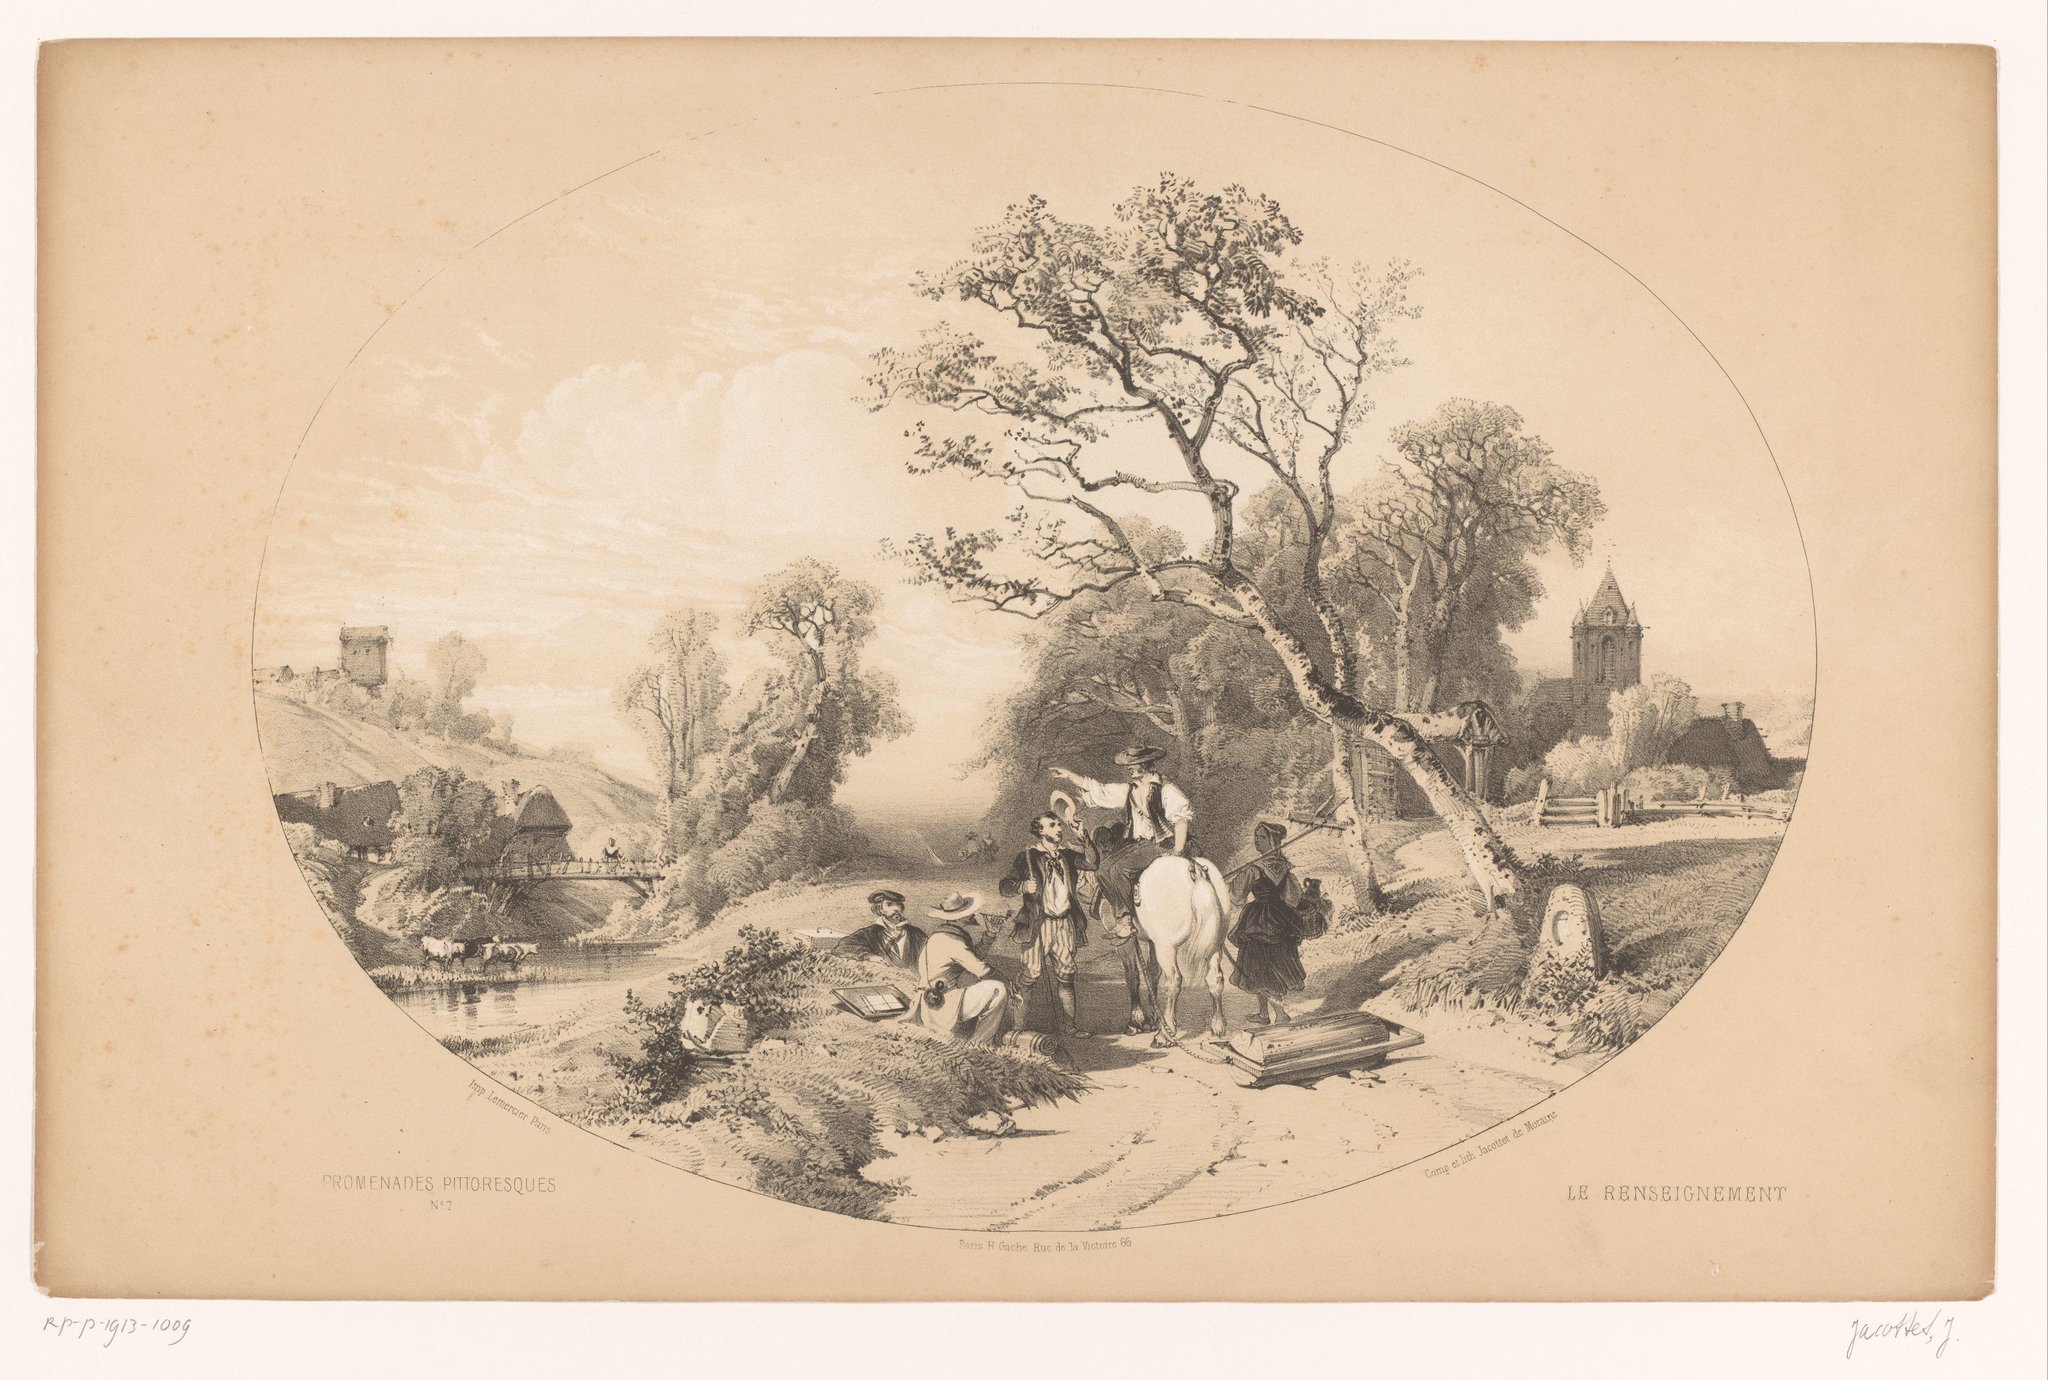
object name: print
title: Pittoreske wandelingen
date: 1850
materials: paper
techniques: tone lithography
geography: paris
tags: riding a horse, ass, or mule; rider, horseman, asking the way, prospect of village, silhouette of village (+ city(-scape) with figures, staffage)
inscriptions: collector's mark: Lugt 2228a